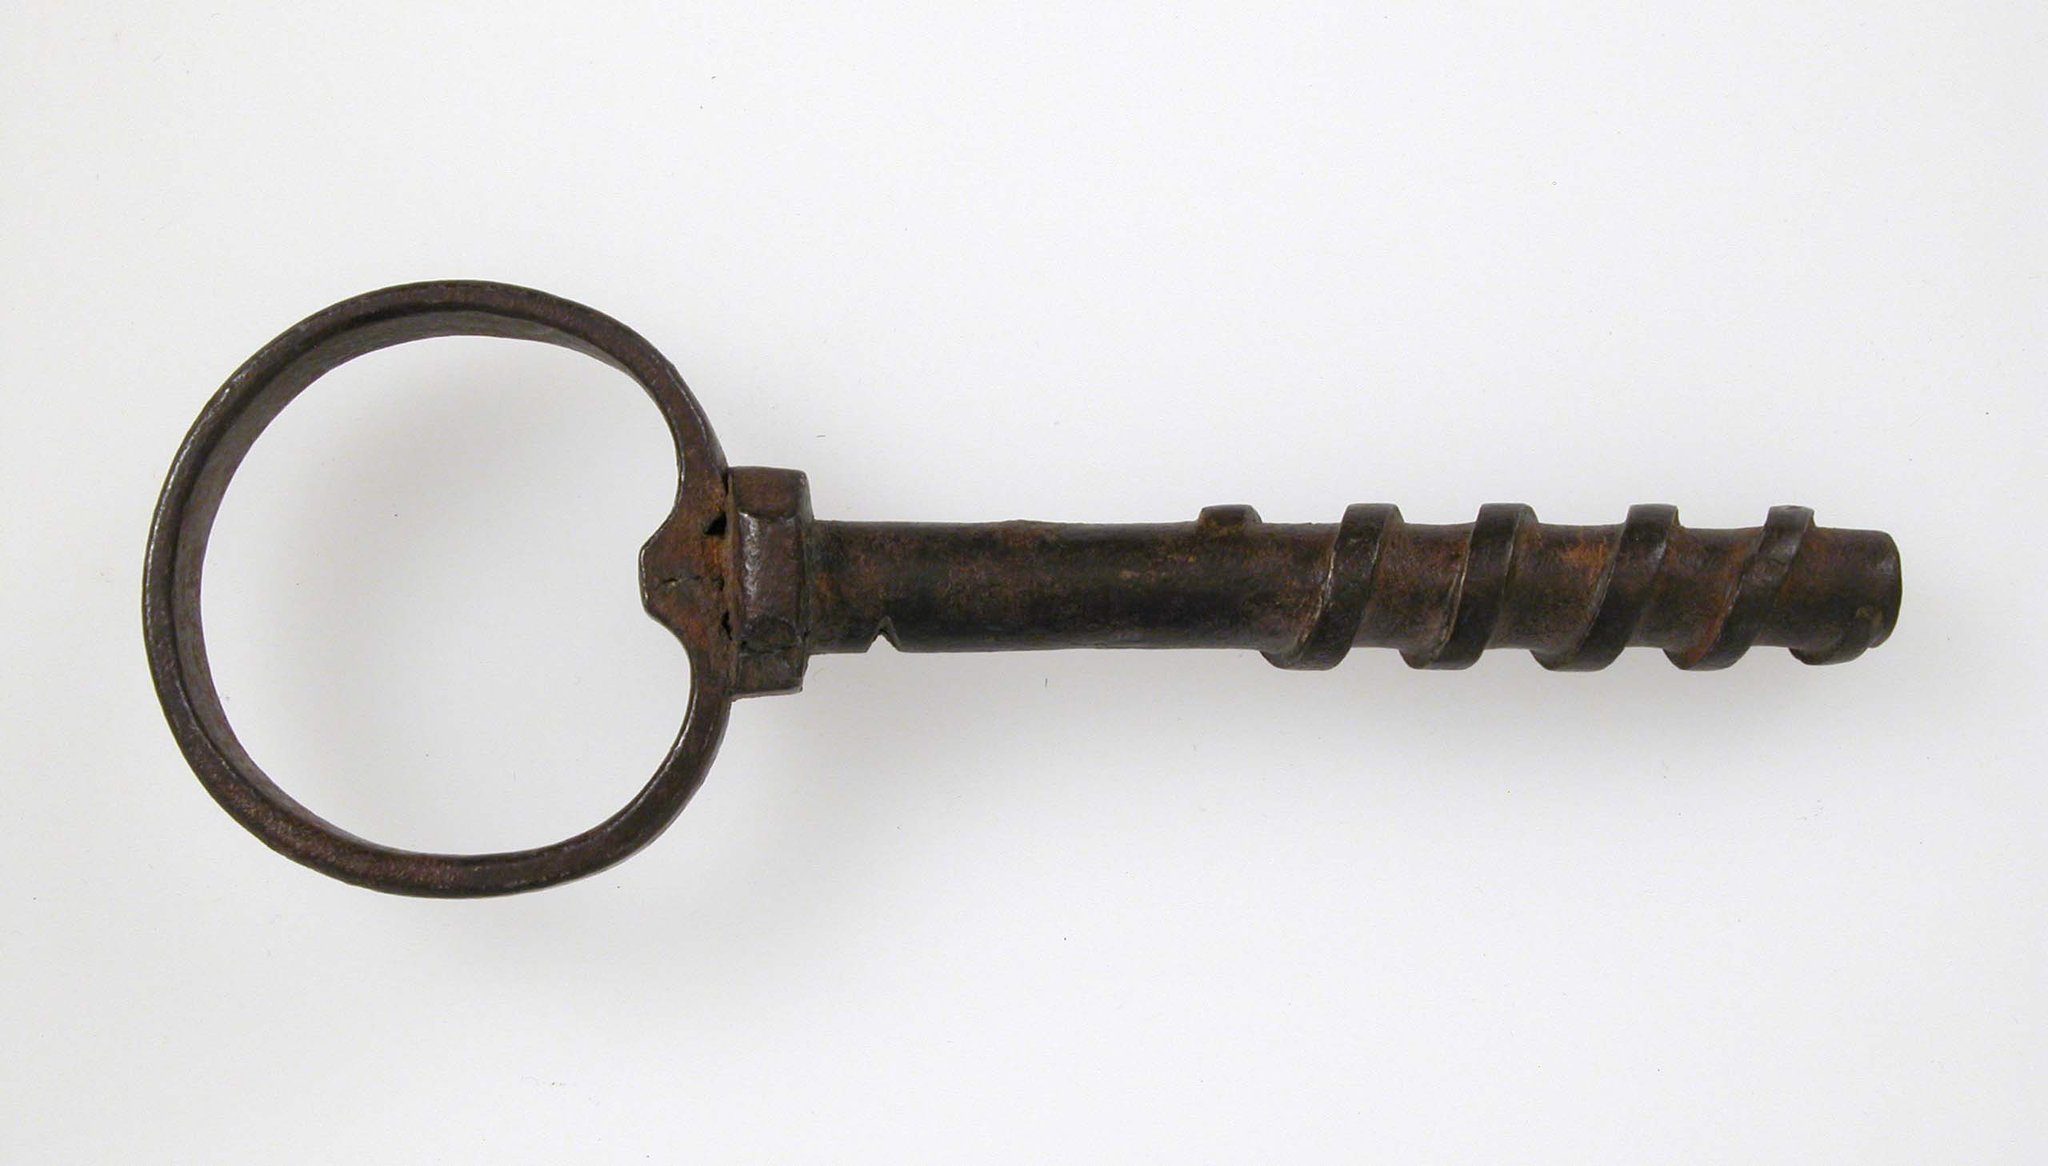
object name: key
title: Spiral Key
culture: german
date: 1501-1533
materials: iron